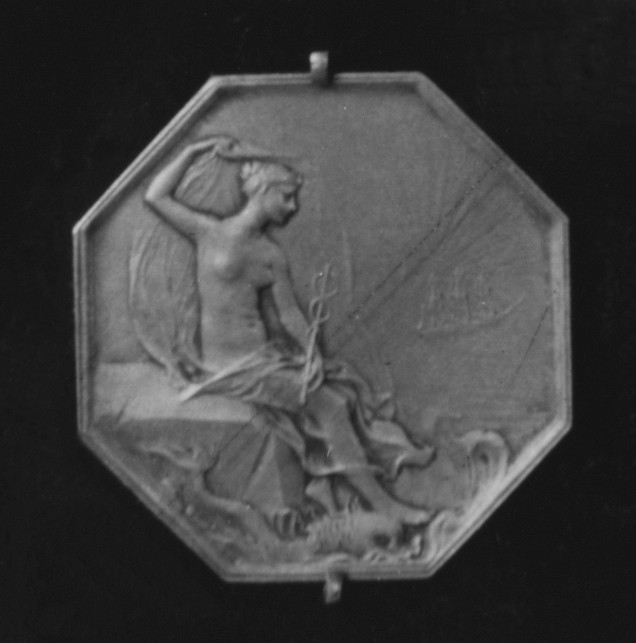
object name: jeton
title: Memorial of opening of Chamber of Commerce of St. Nazaire, 1879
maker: louis-oscar roty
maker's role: artist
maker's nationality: french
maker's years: 1846-1911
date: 1893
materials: bronze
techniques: silvered, struck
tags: female nudes